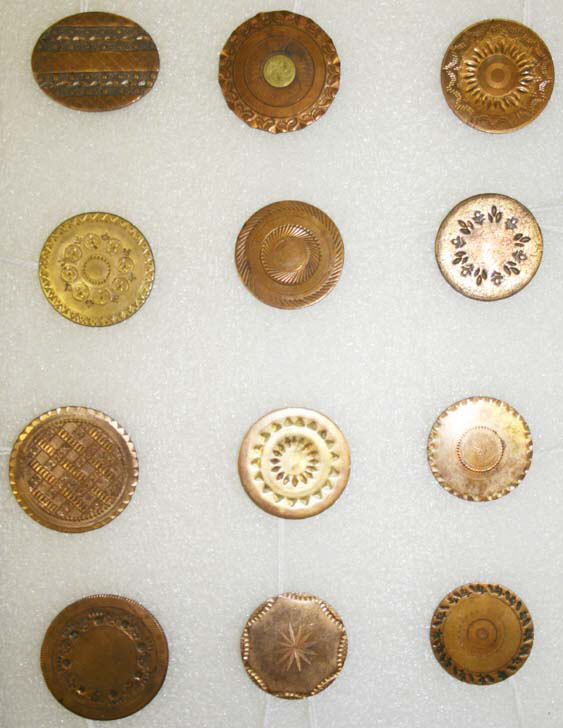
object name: button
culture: american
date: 1770-1800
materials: bone, wood